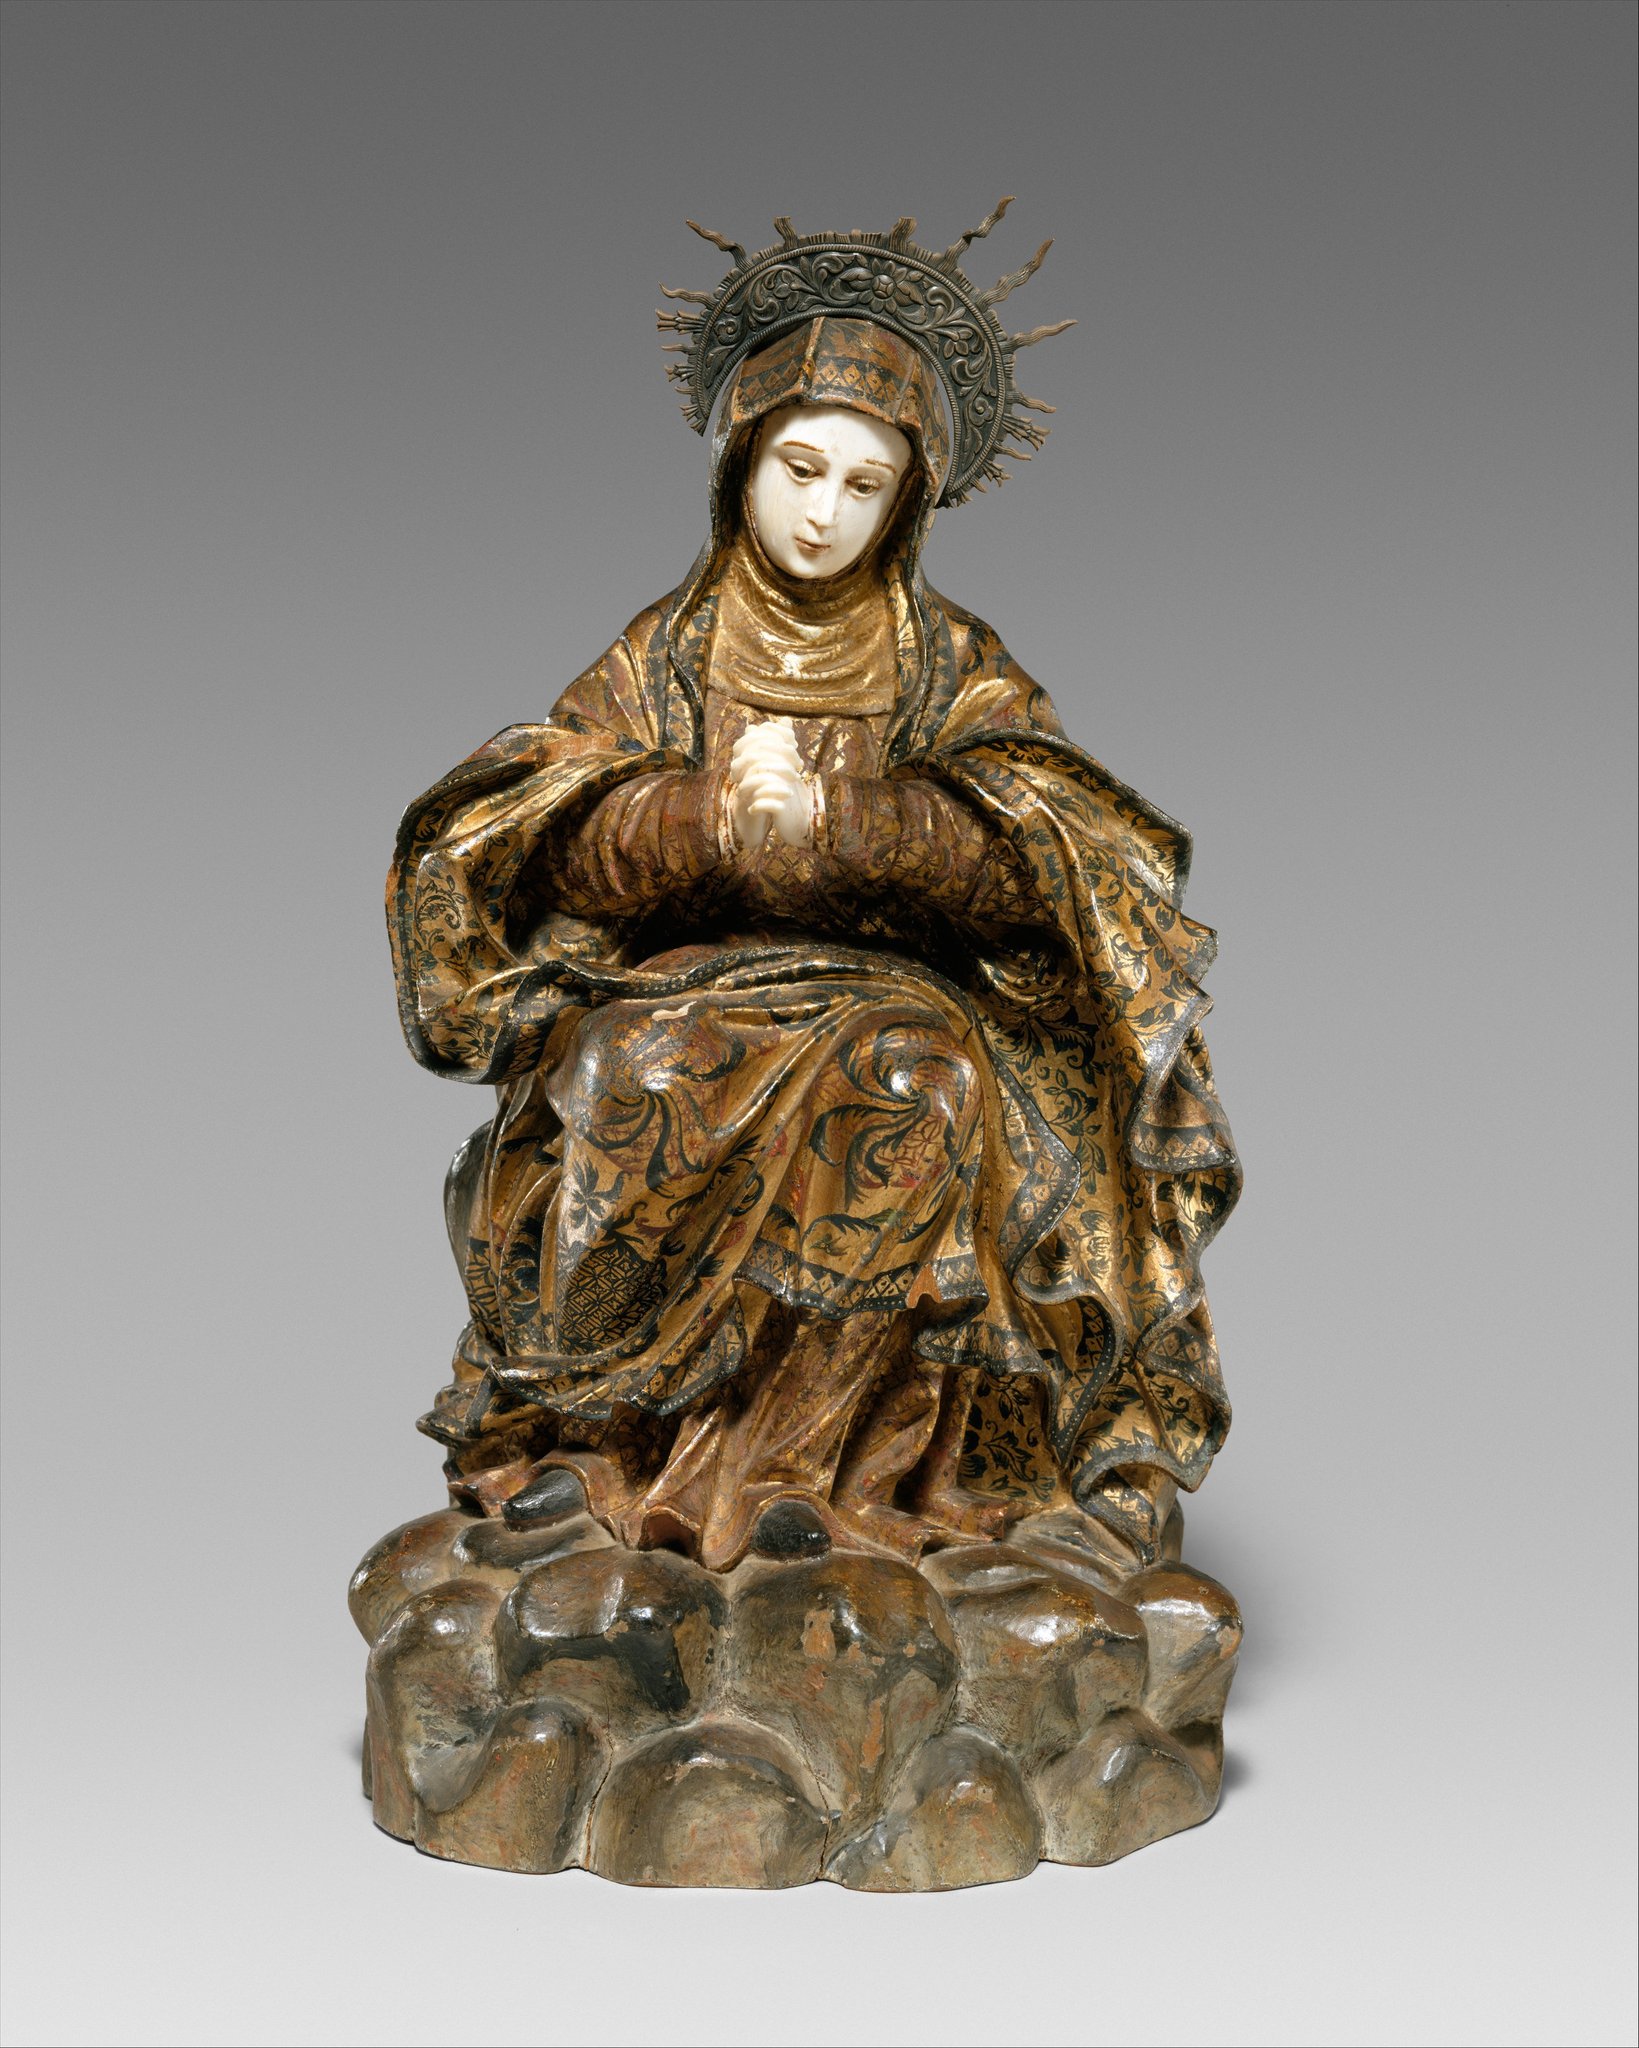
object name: figure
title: Mater Dolorosa (Mourning Virgin)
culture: chinese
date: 1701-1800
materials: ivory, pigment, silver, wood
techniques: gilding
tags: virgin mary